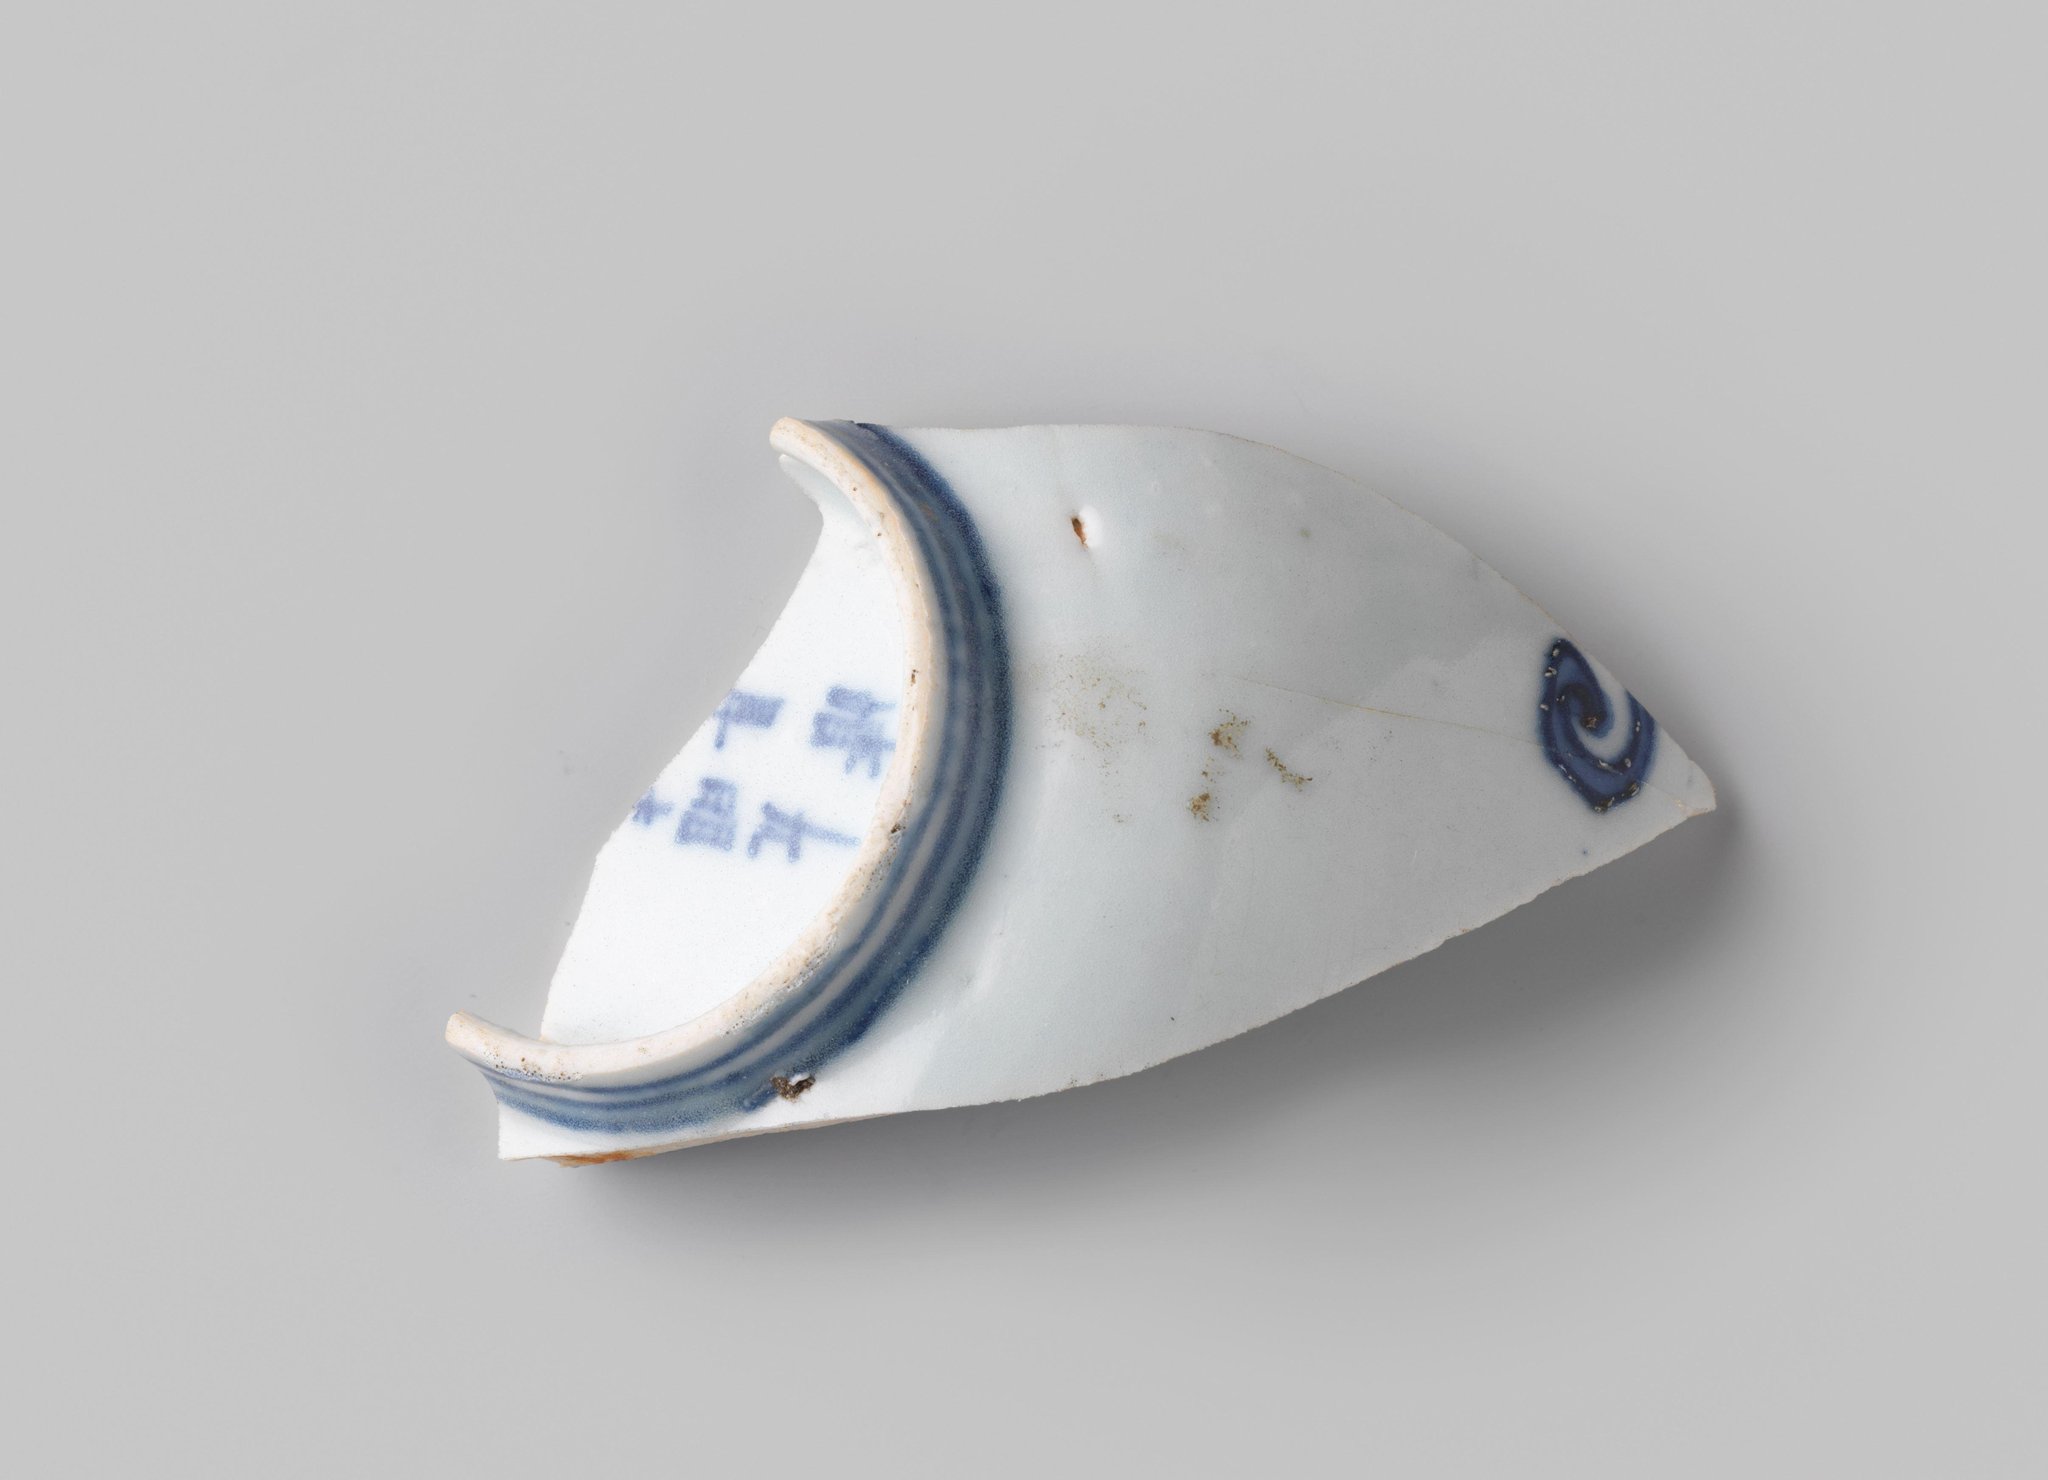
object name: bowl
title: Fragment kom uit V.O.C.-schip de 'Witte Leeuw'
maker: Anonymous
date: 1613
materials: porcelain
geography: jingdezhen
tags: verenigde oostindische compagnie, sint-helena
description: A dish with a flattened rim. In the centre part of a lion is visible, encircled by a single band. The outside is fairly undecorated. Bands are drawn around the foot-ring. On the base part of a six character mark is visible: ta ming (jia) jing (1522-1566).